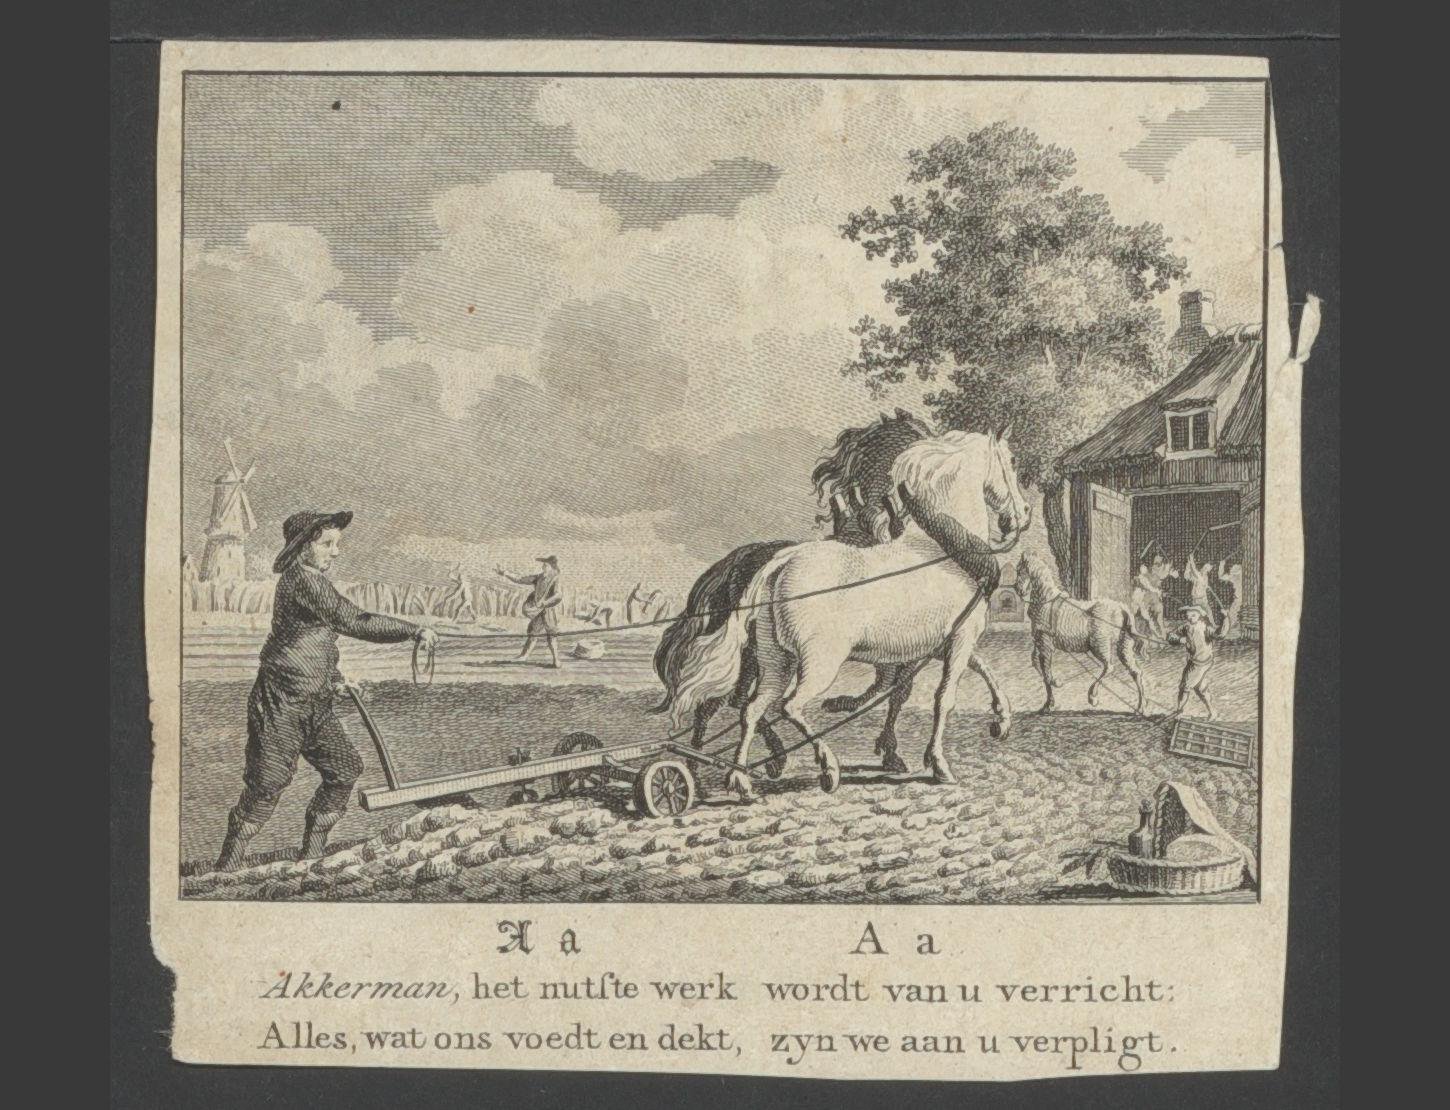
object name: book illustration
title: Man bewerkt een akker met een ploeg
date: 1781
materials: paper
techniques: engraving, etching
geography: amsterdam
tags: letters, alphabet, script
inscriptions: stamp, collector's mark: Lugt 1641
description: Man bewerkt een akker met een ploeg. Onder de voorstelling de letter A in twee verschillende lettertypes. Onderaan een tweeregelig vers over de akkerman. Onderwerpsrubrieken binnen de Atlas Zeden en Gewoonten: Onderwijs en Wetenschappen, Opvoeding en Onderwijs, Haneboeken en schoolprenten.